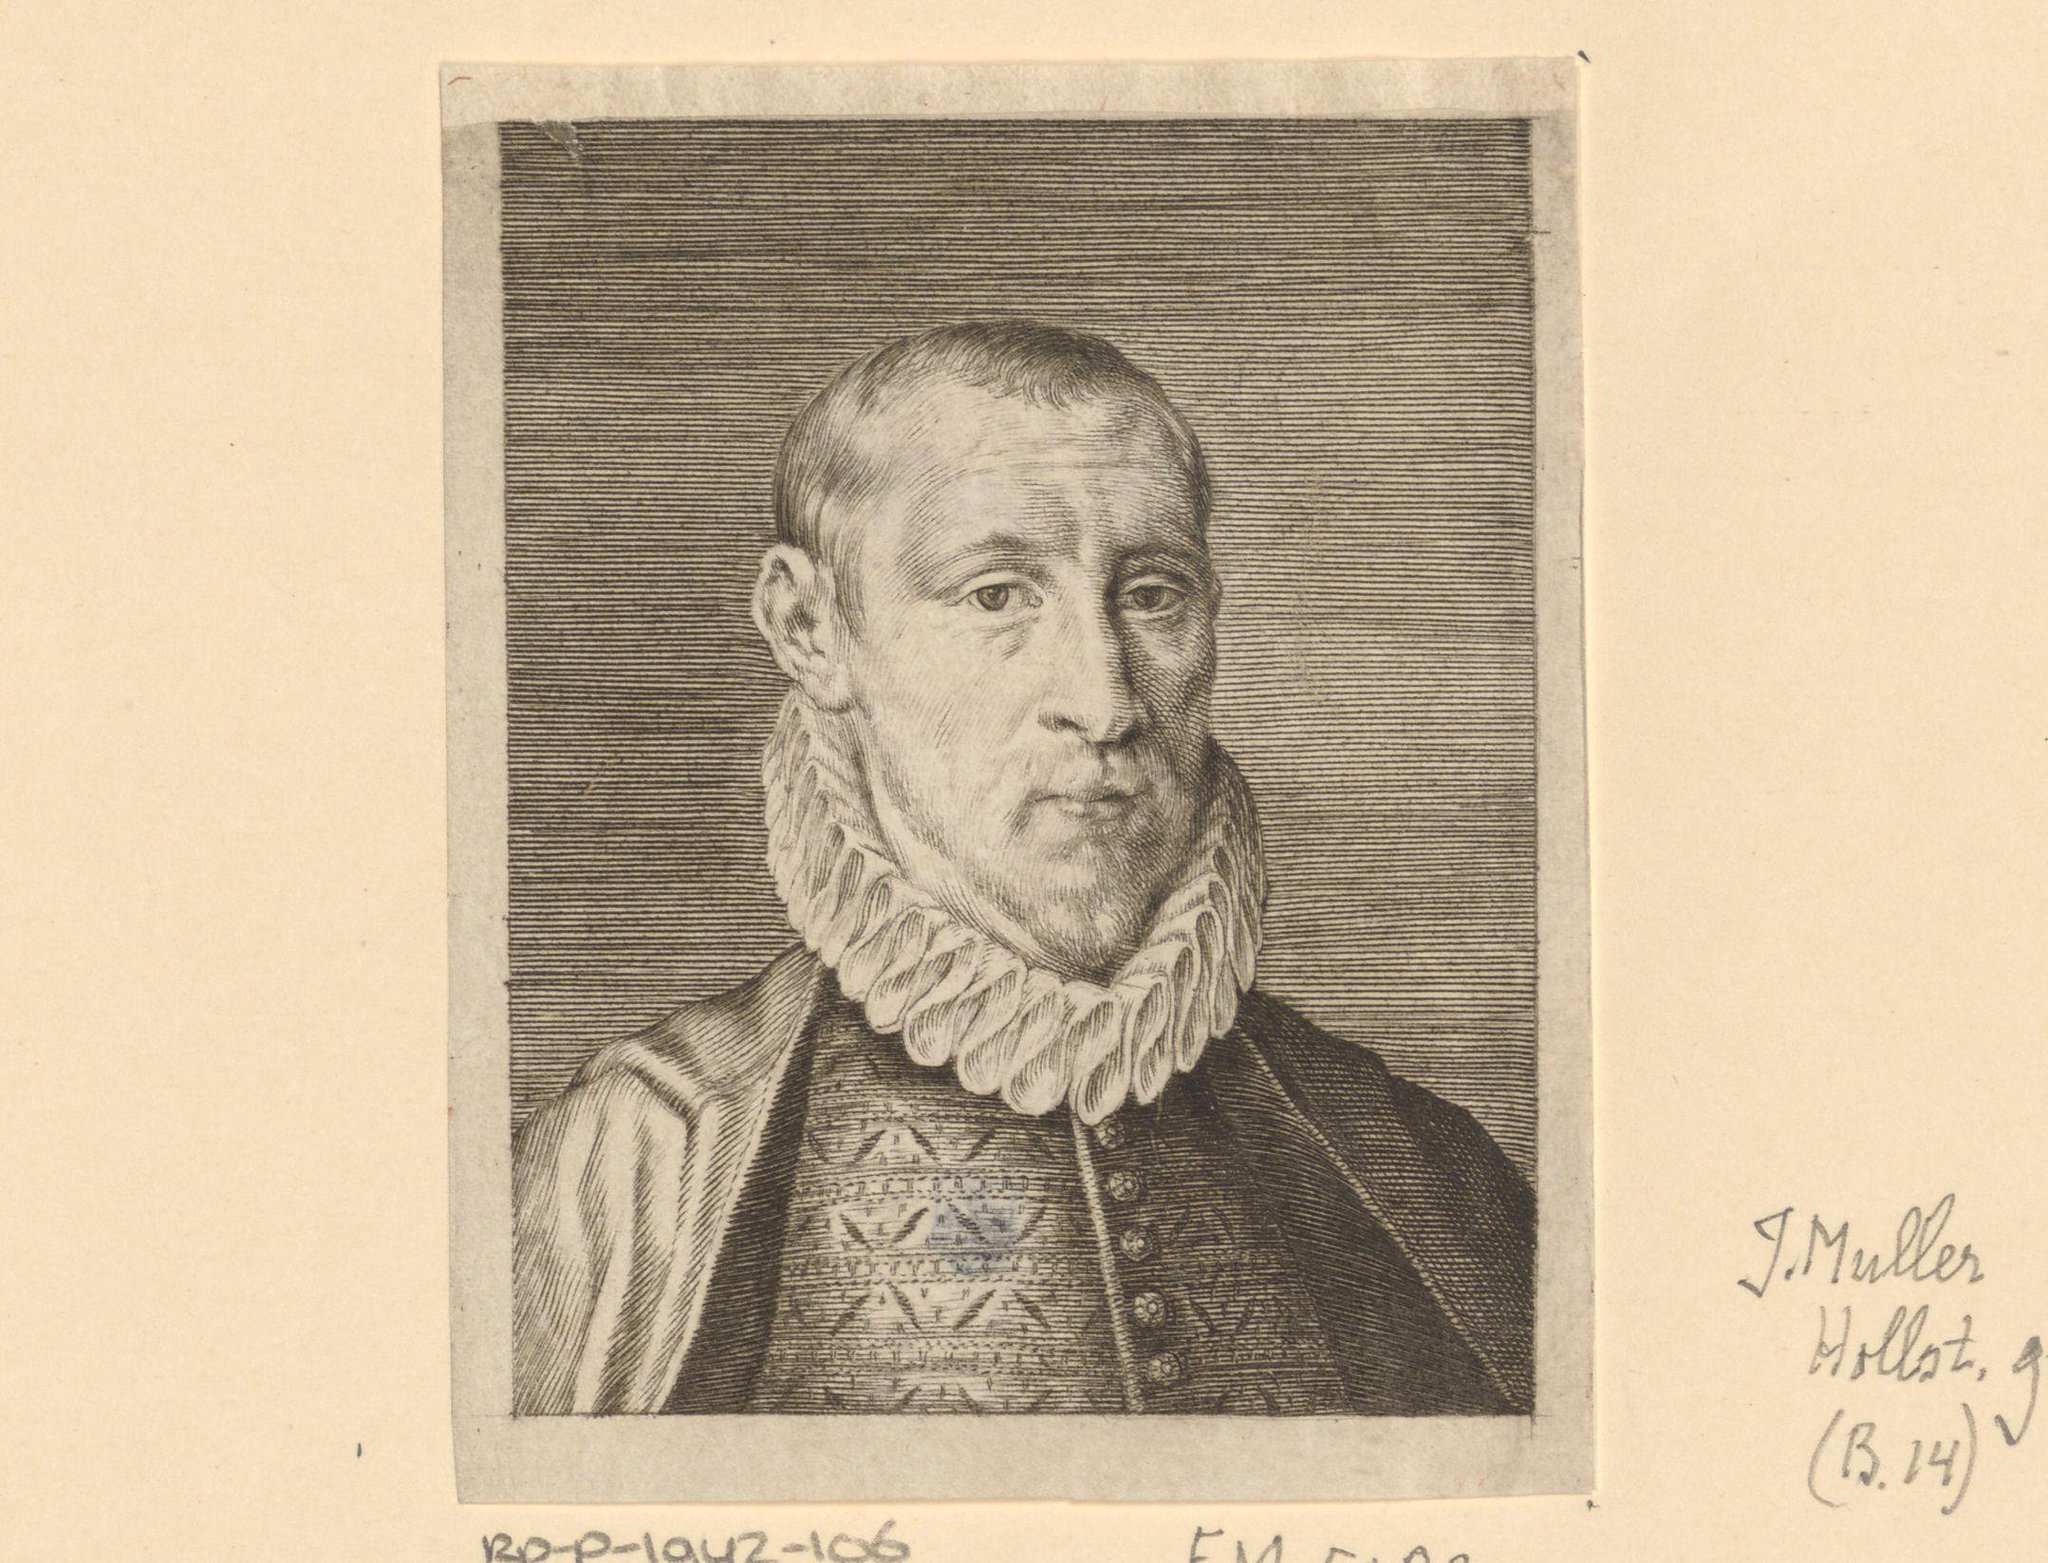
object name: print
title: Portret van Hendrick Laurensz. Spieghel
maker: jan harmensz. muller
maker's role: draughtsman, print maker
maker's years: 1571-1628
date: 1614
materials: paper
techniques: engraving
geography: amsterdam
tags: amsterdam, hendrick laurensz. spieghel, historical persons, portrait of a writer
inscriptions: collector's mark: Lugt 2760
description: Latere staat van de prent met tekst in boekdruk gebruikt in: Spieghel, Hendrick Laurensz. Hart-spieghel. Amsterdam: Cornelis Dircksz Cool (I), 1615.